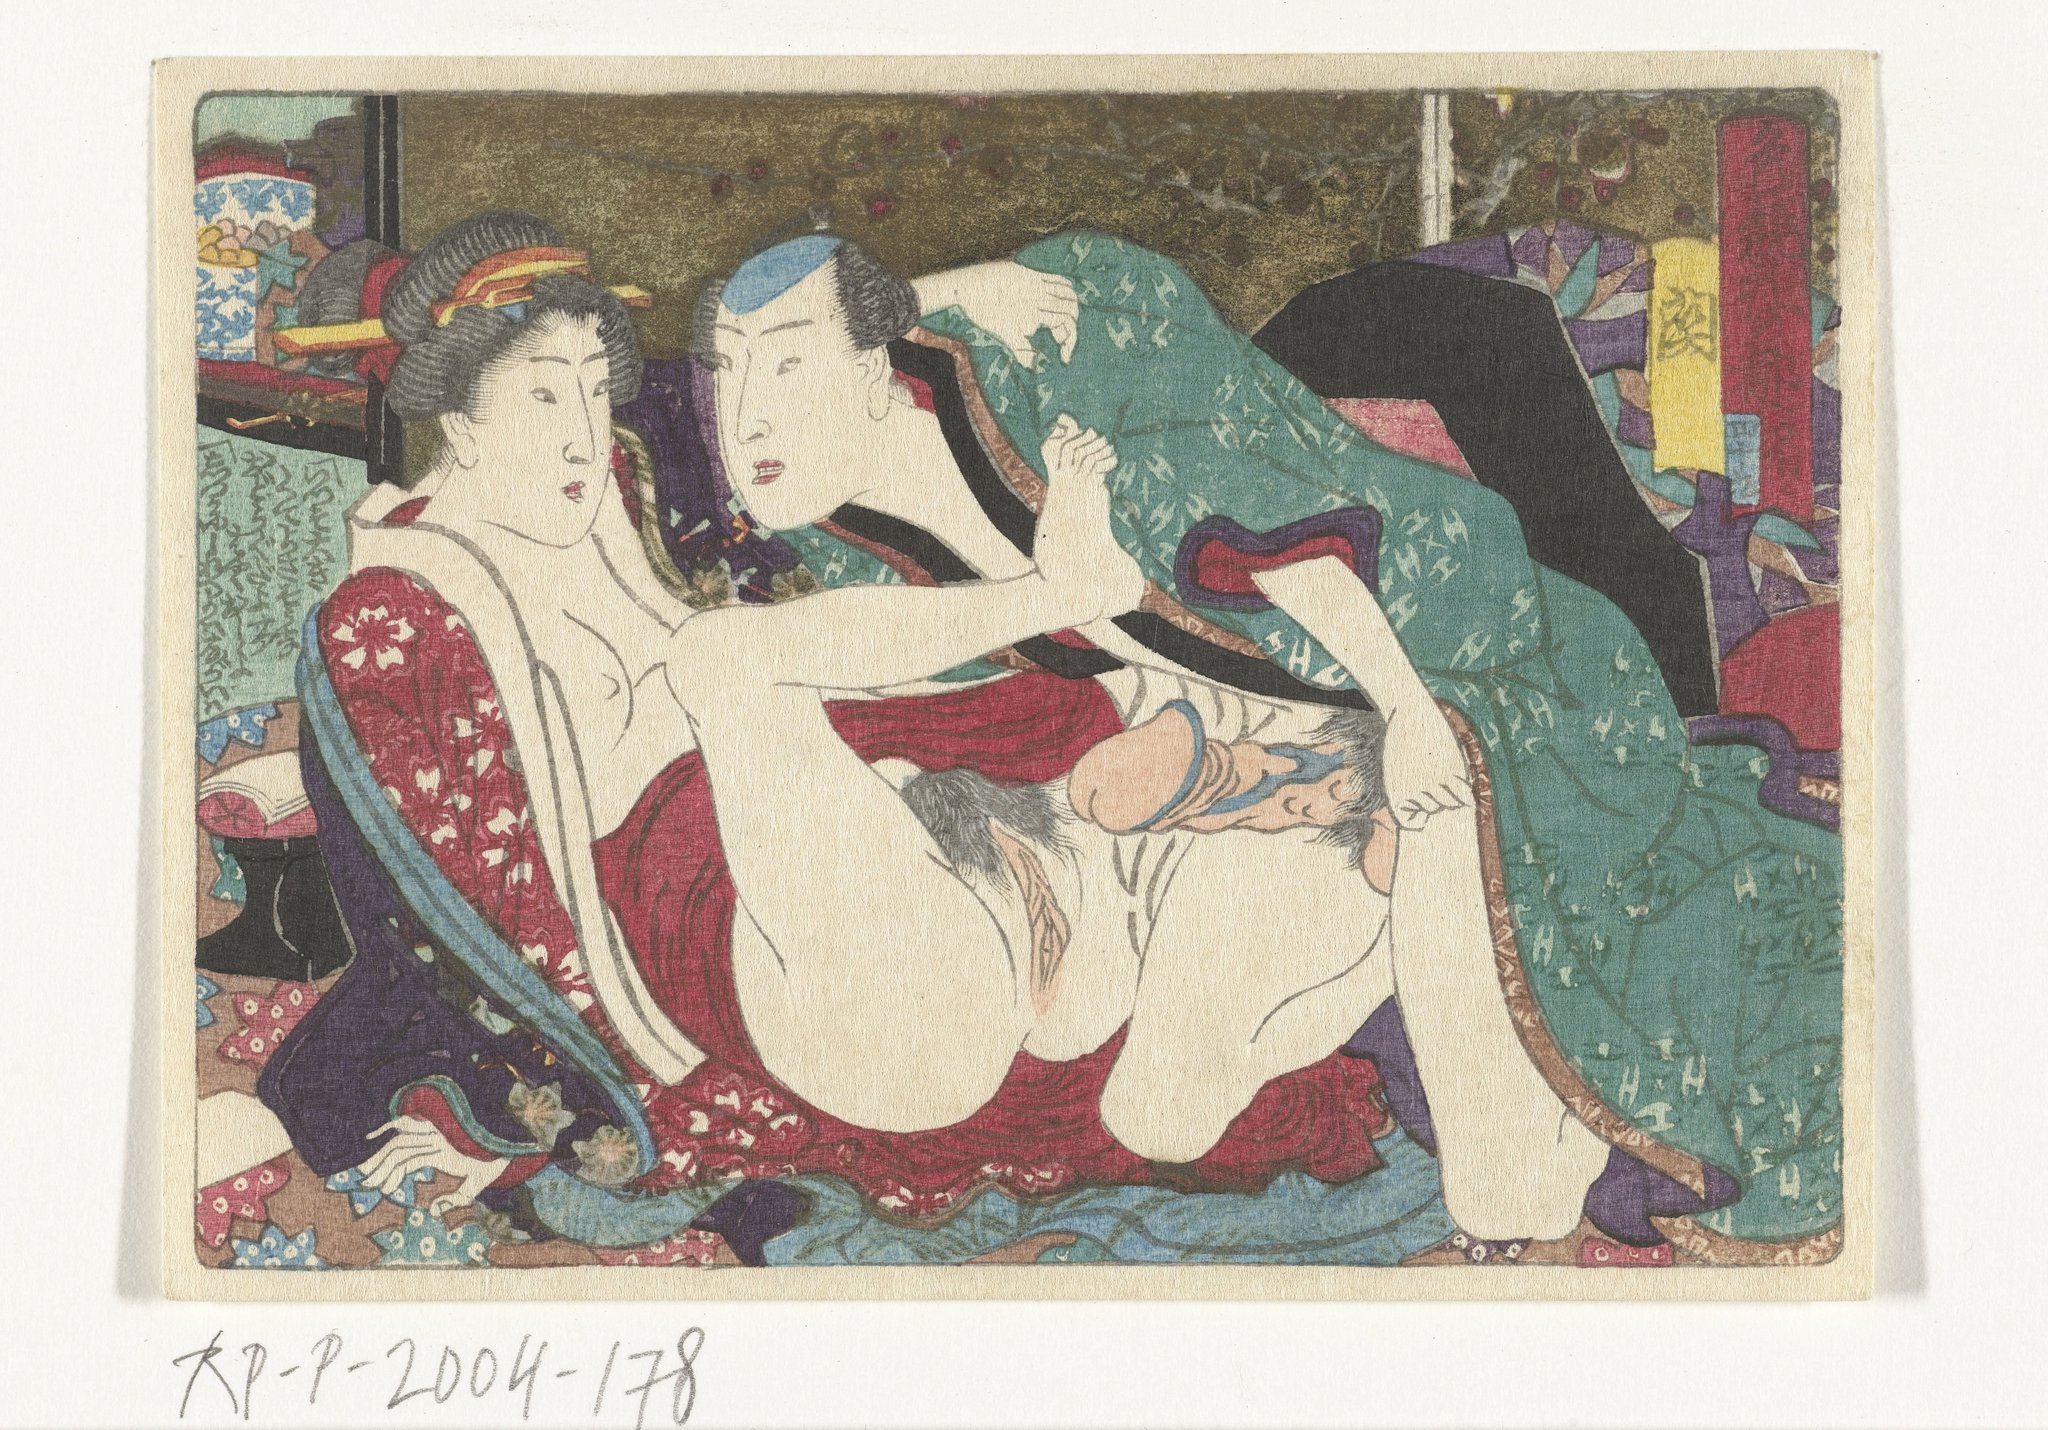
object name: print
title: De erotische weg naar de hoofdstad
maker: utagawa kunisada (i)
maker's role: print maker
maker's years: 1786-1865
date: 1835-1845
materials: gold powder, paper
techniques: blind stamped, woodcut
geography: japan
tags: coitus, cohabiting, sexual intercourse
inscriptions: collector's mark: Lugt 2760, collector's mark: Lugt 2228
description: Liefdespaar bij goudkleurig kamerscherm met schildering van pruimenbloesemtakken.